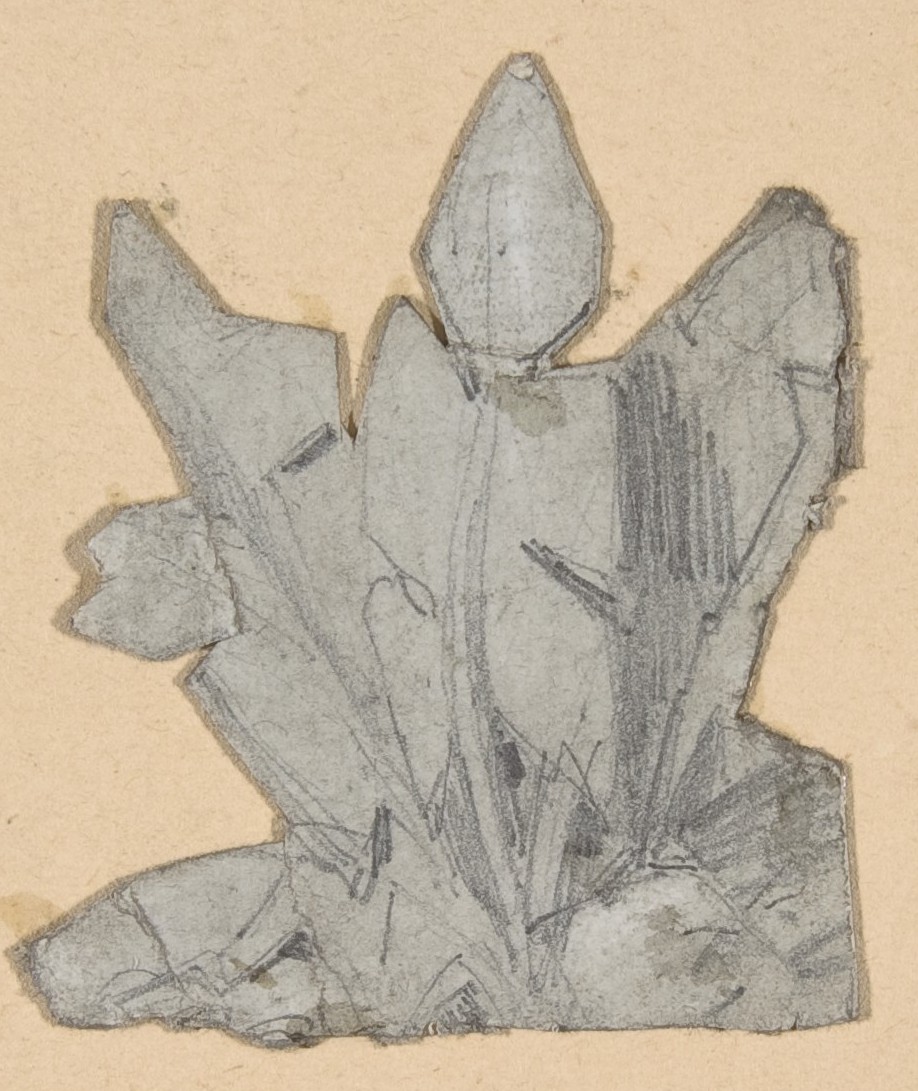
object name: drawing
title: Design for a Stage Set at the Opéra, Paris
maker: eugène cicéri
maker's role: artist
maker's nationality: french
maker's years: 1813-1890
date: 1830-1890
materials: graphite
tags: stage design